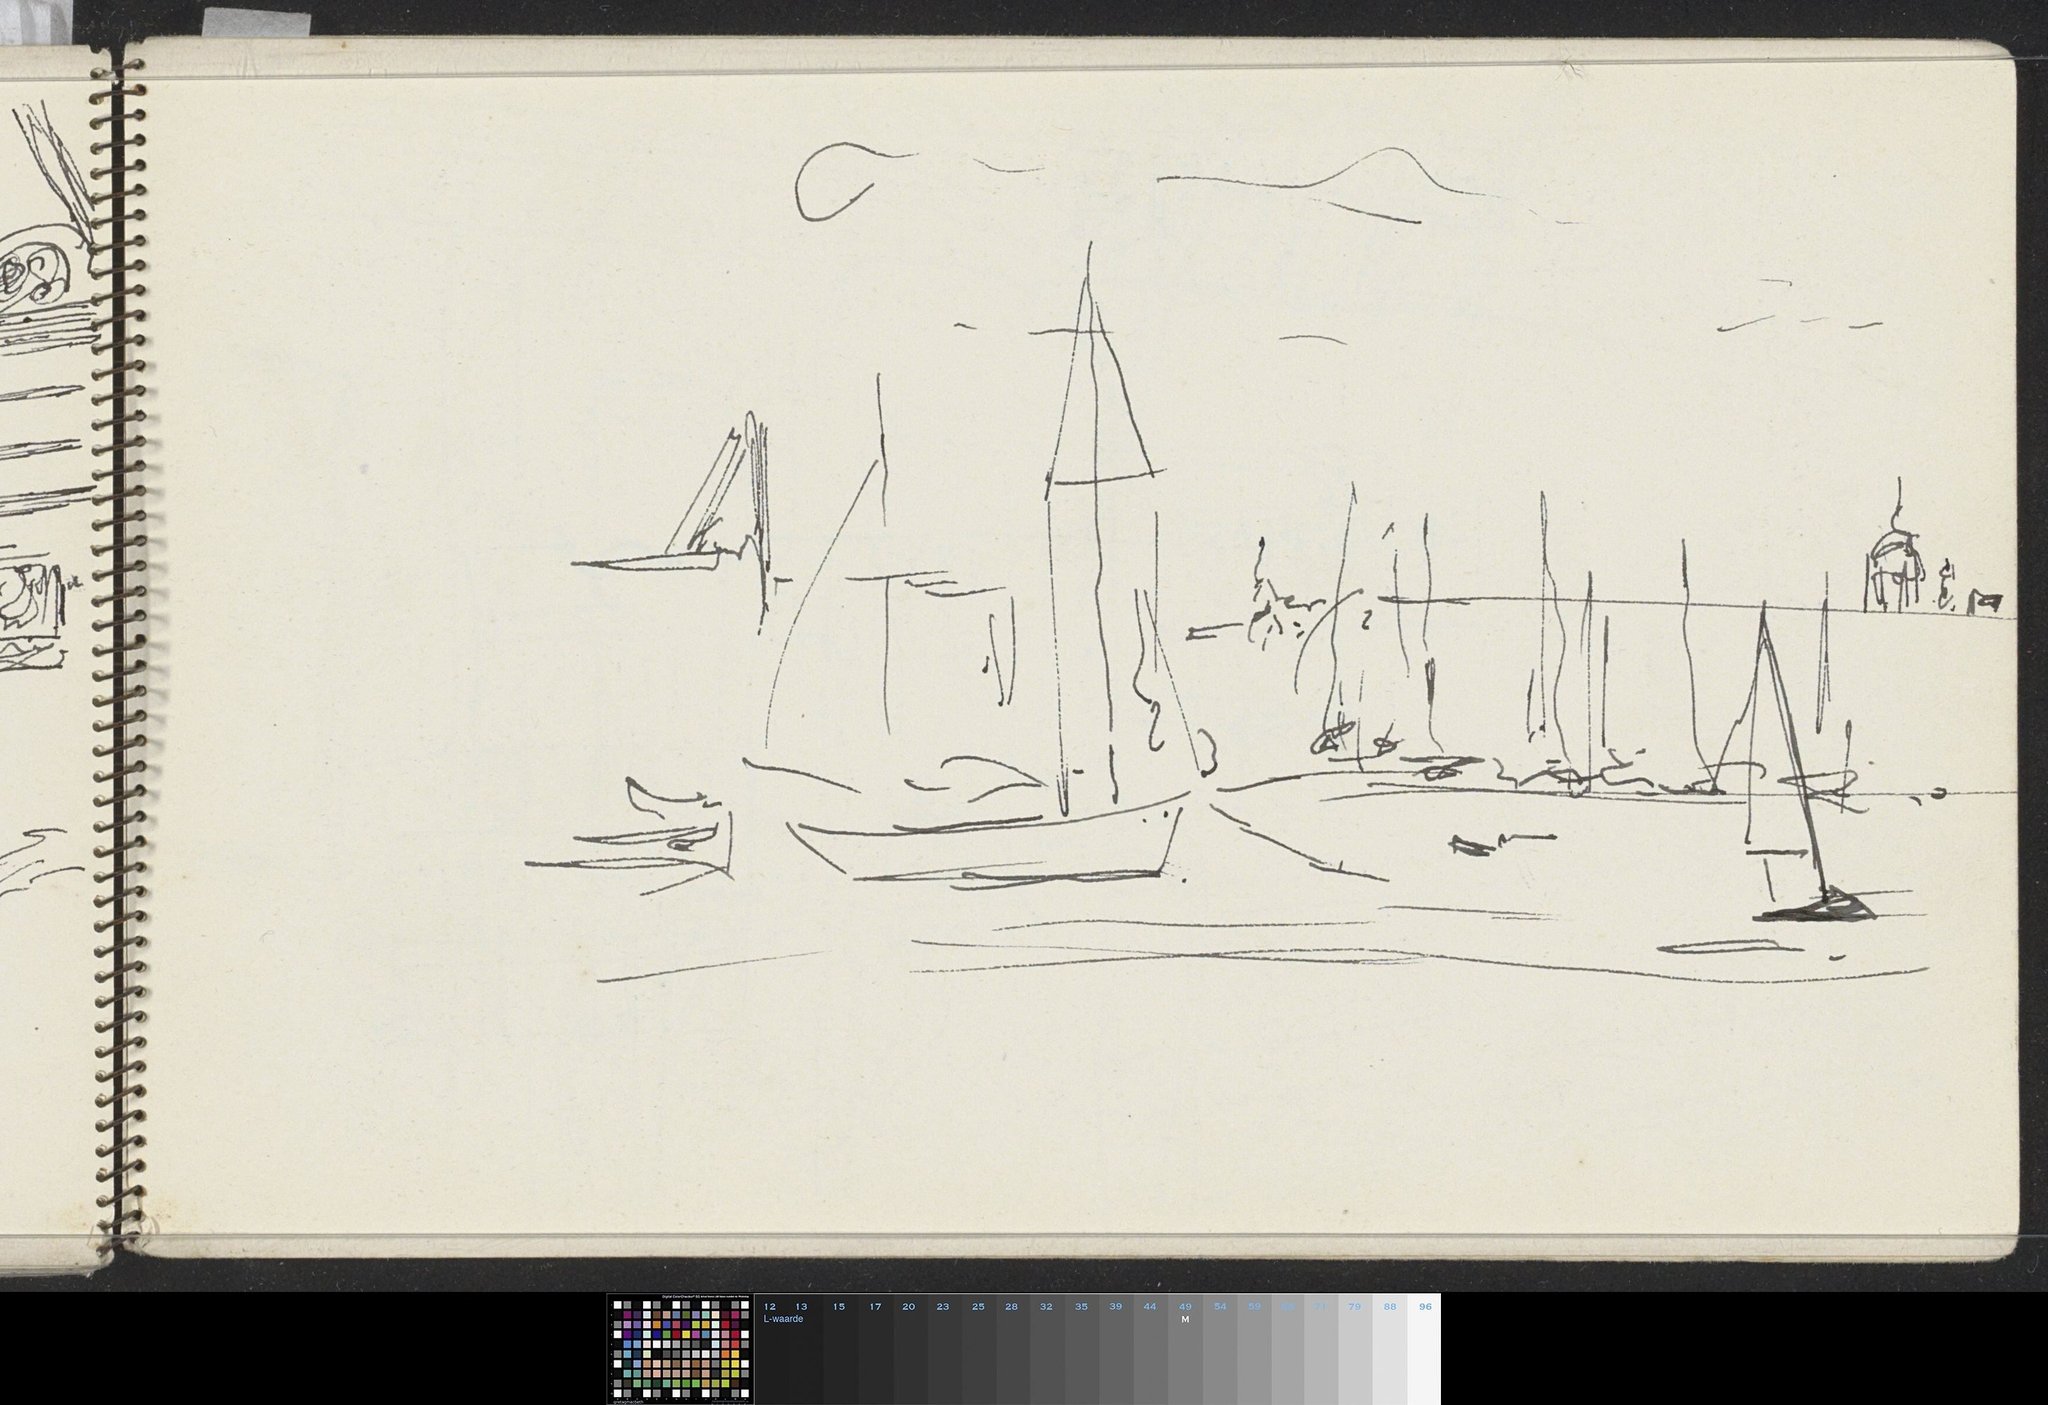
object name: sketchbook leaf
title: Zeilschepen op het water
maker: carel adolph lion cachet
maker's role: draughtsman, print maker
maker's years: 1864-1945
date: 1930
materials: ink, paper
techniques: pen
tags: sailing-ship, sailing-boat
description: Op de achtergrond een toren. Blad 18 recto uit een schetsboek met 20 bladen.